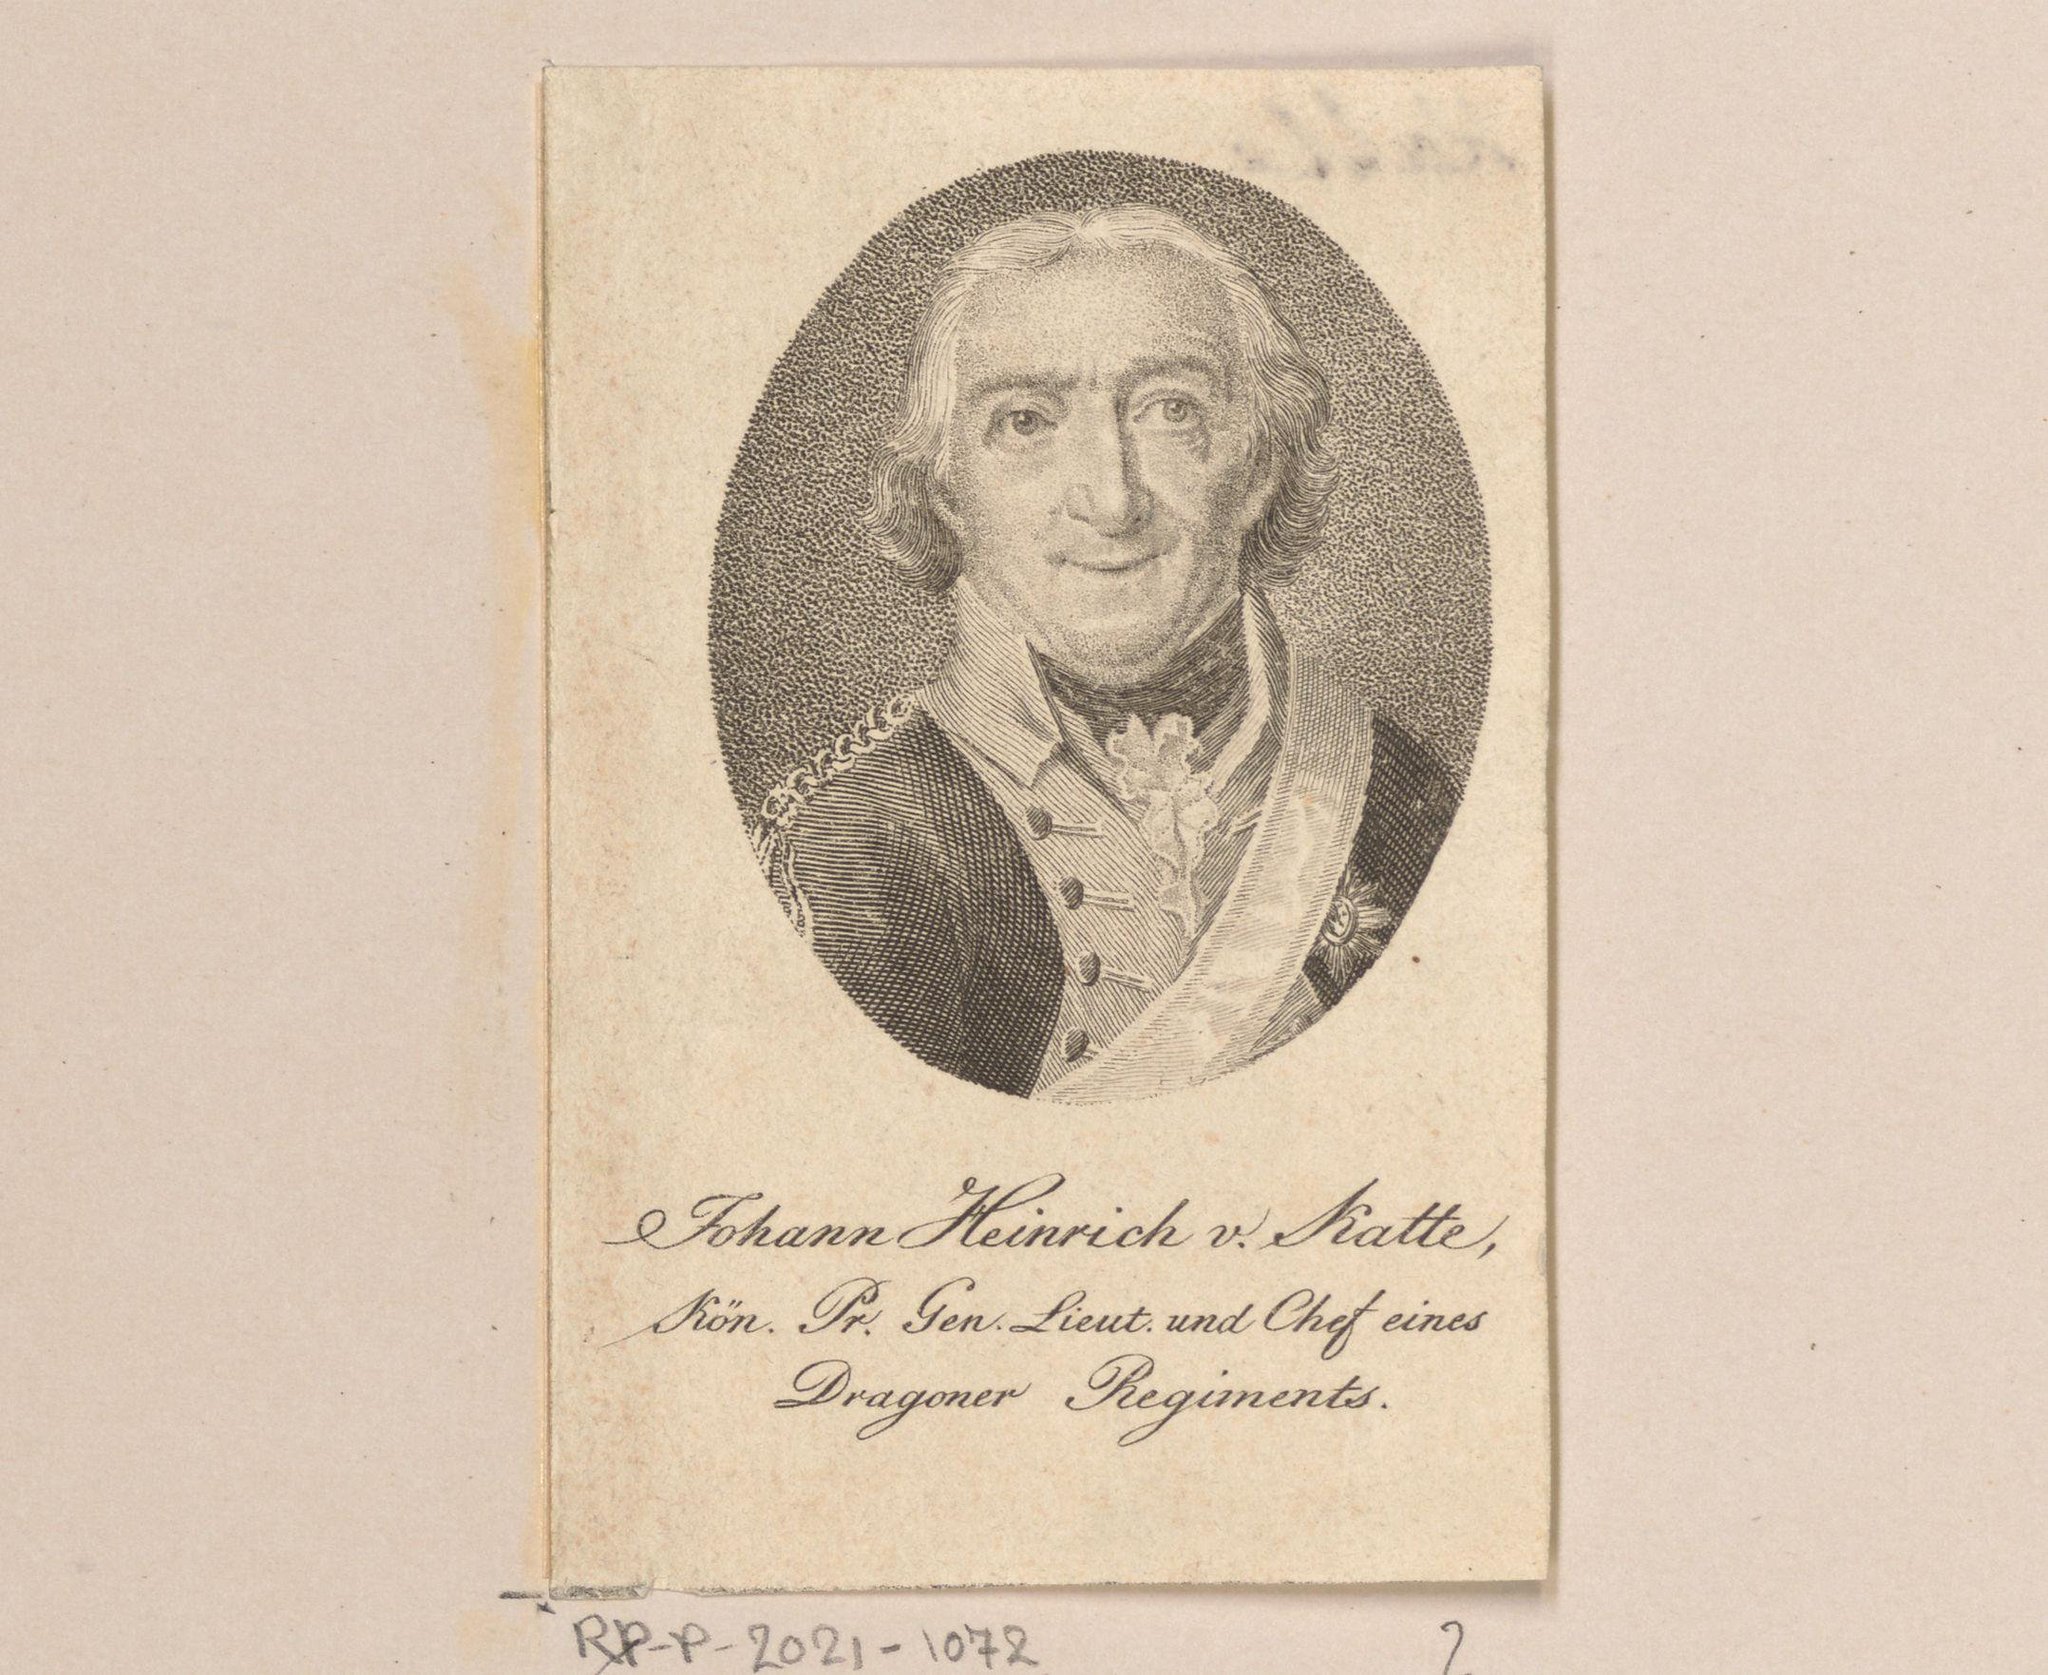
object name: print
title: Portret van Friedrich Heinrich von Katte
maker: Anonymous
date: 1790-1849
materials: paper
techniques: engraving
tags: historical persons